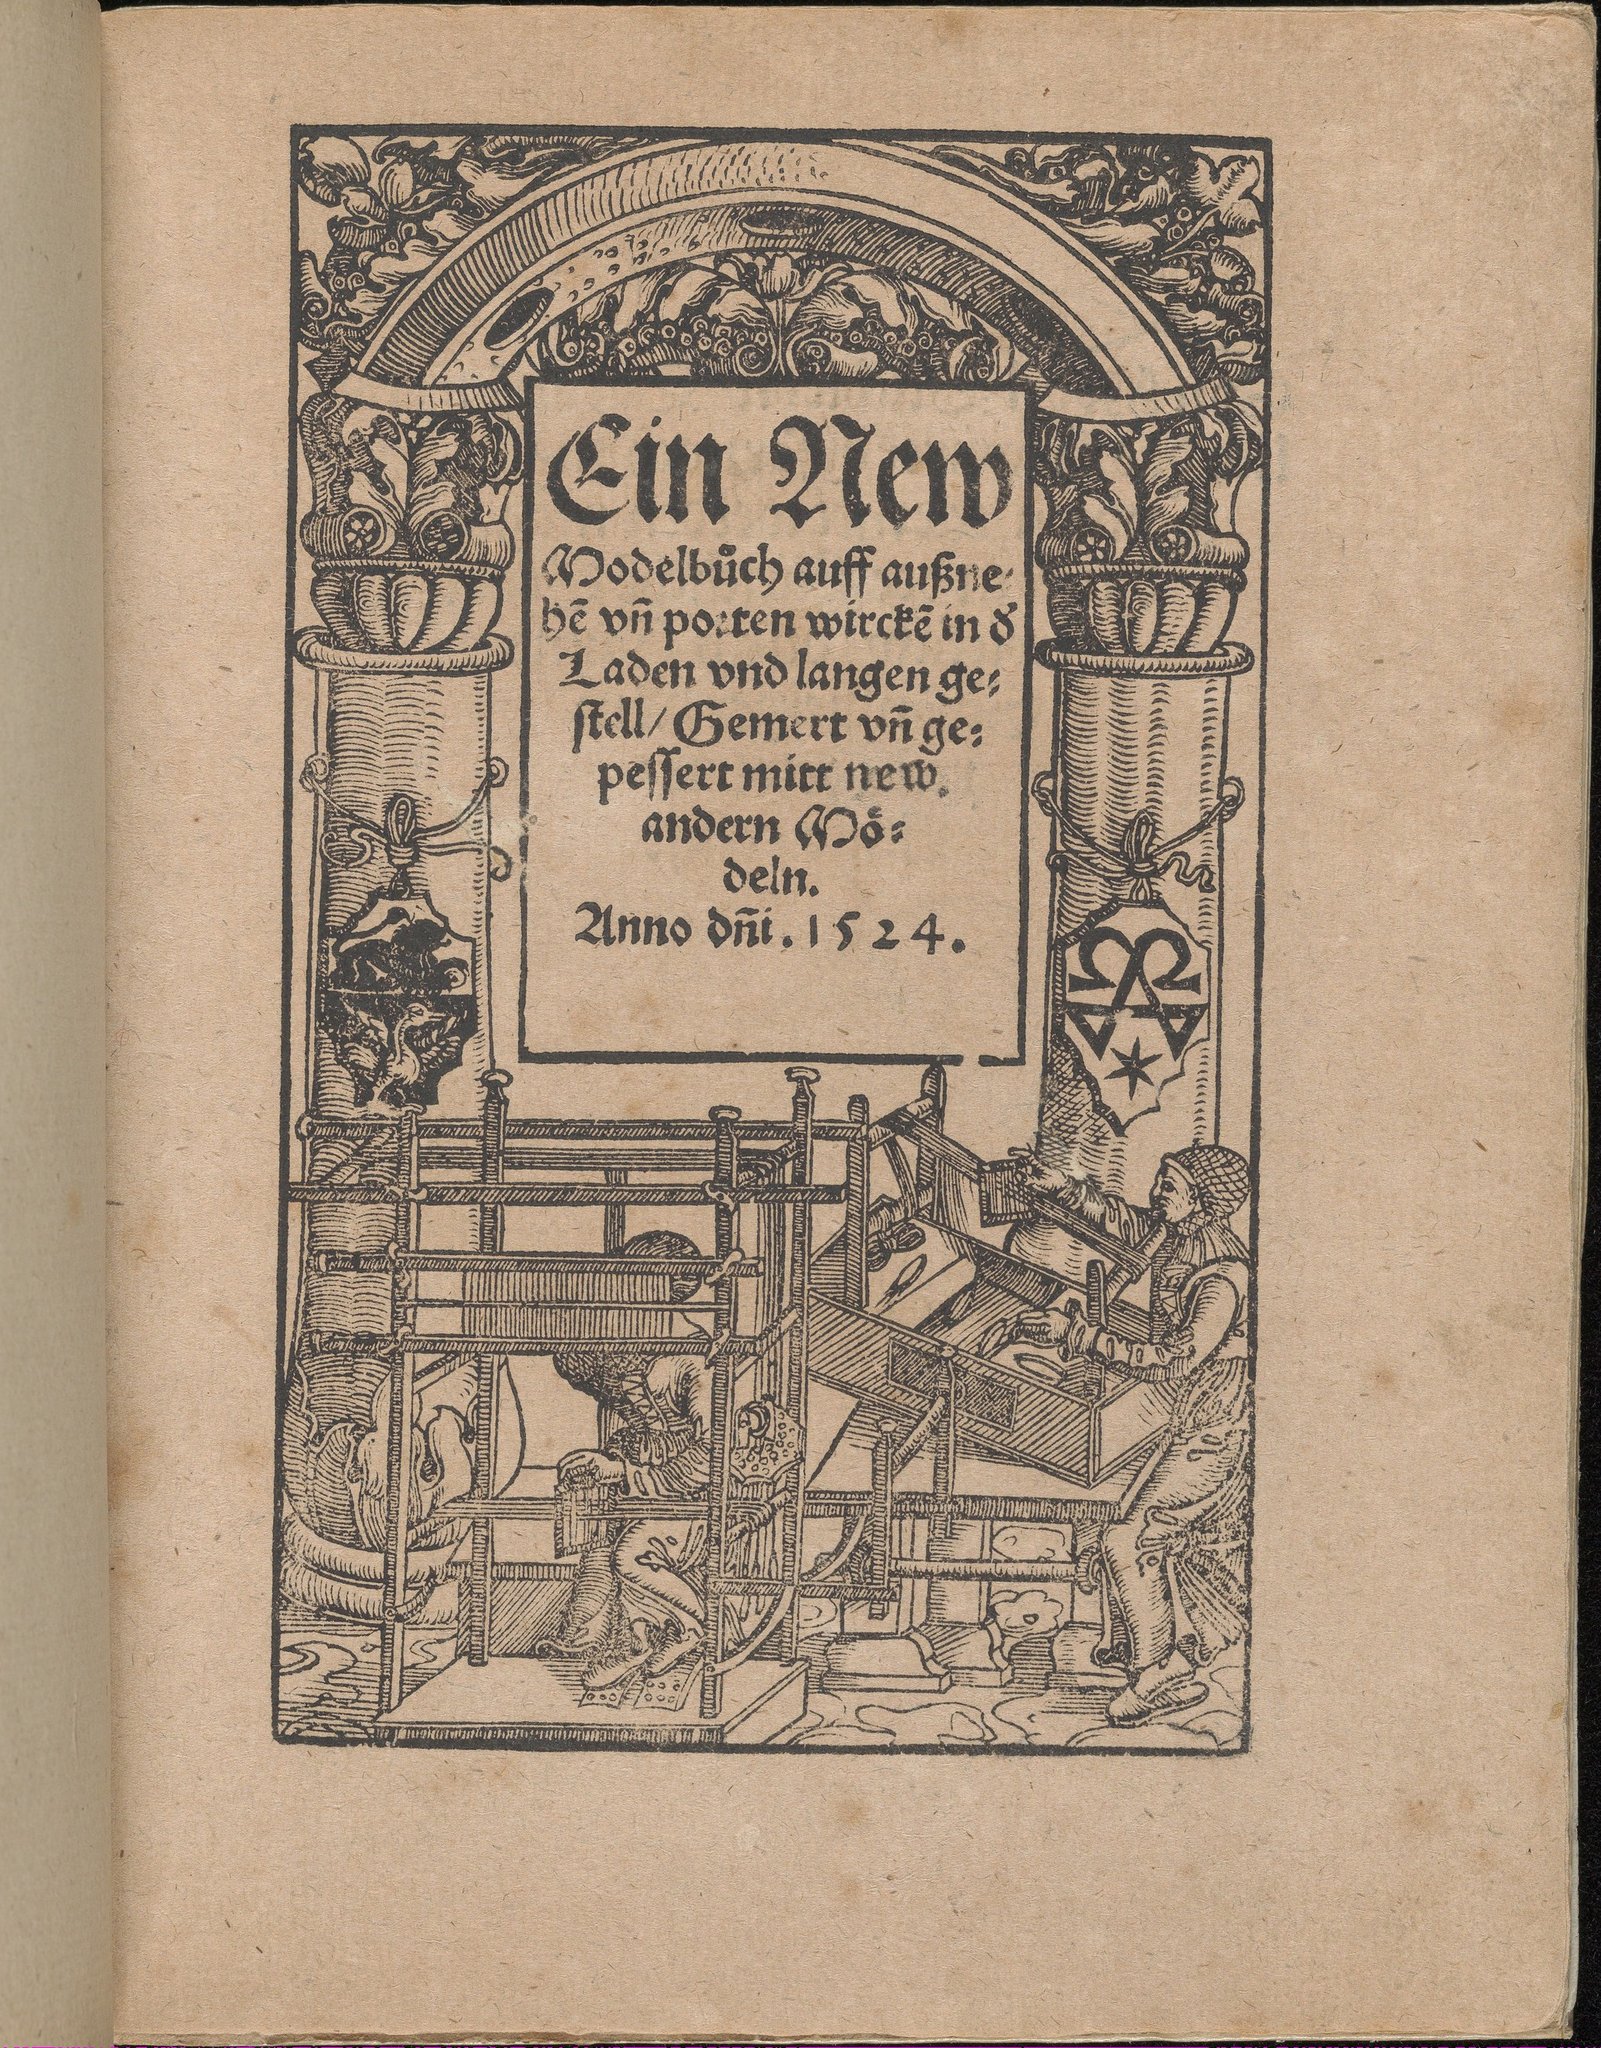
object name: book print ornament architecture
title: Ein new Modelbuch...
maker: johann schönsperger the younger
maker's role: publisher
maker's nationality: german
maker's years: 1490-1550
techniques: woodcut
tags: ornament,looms